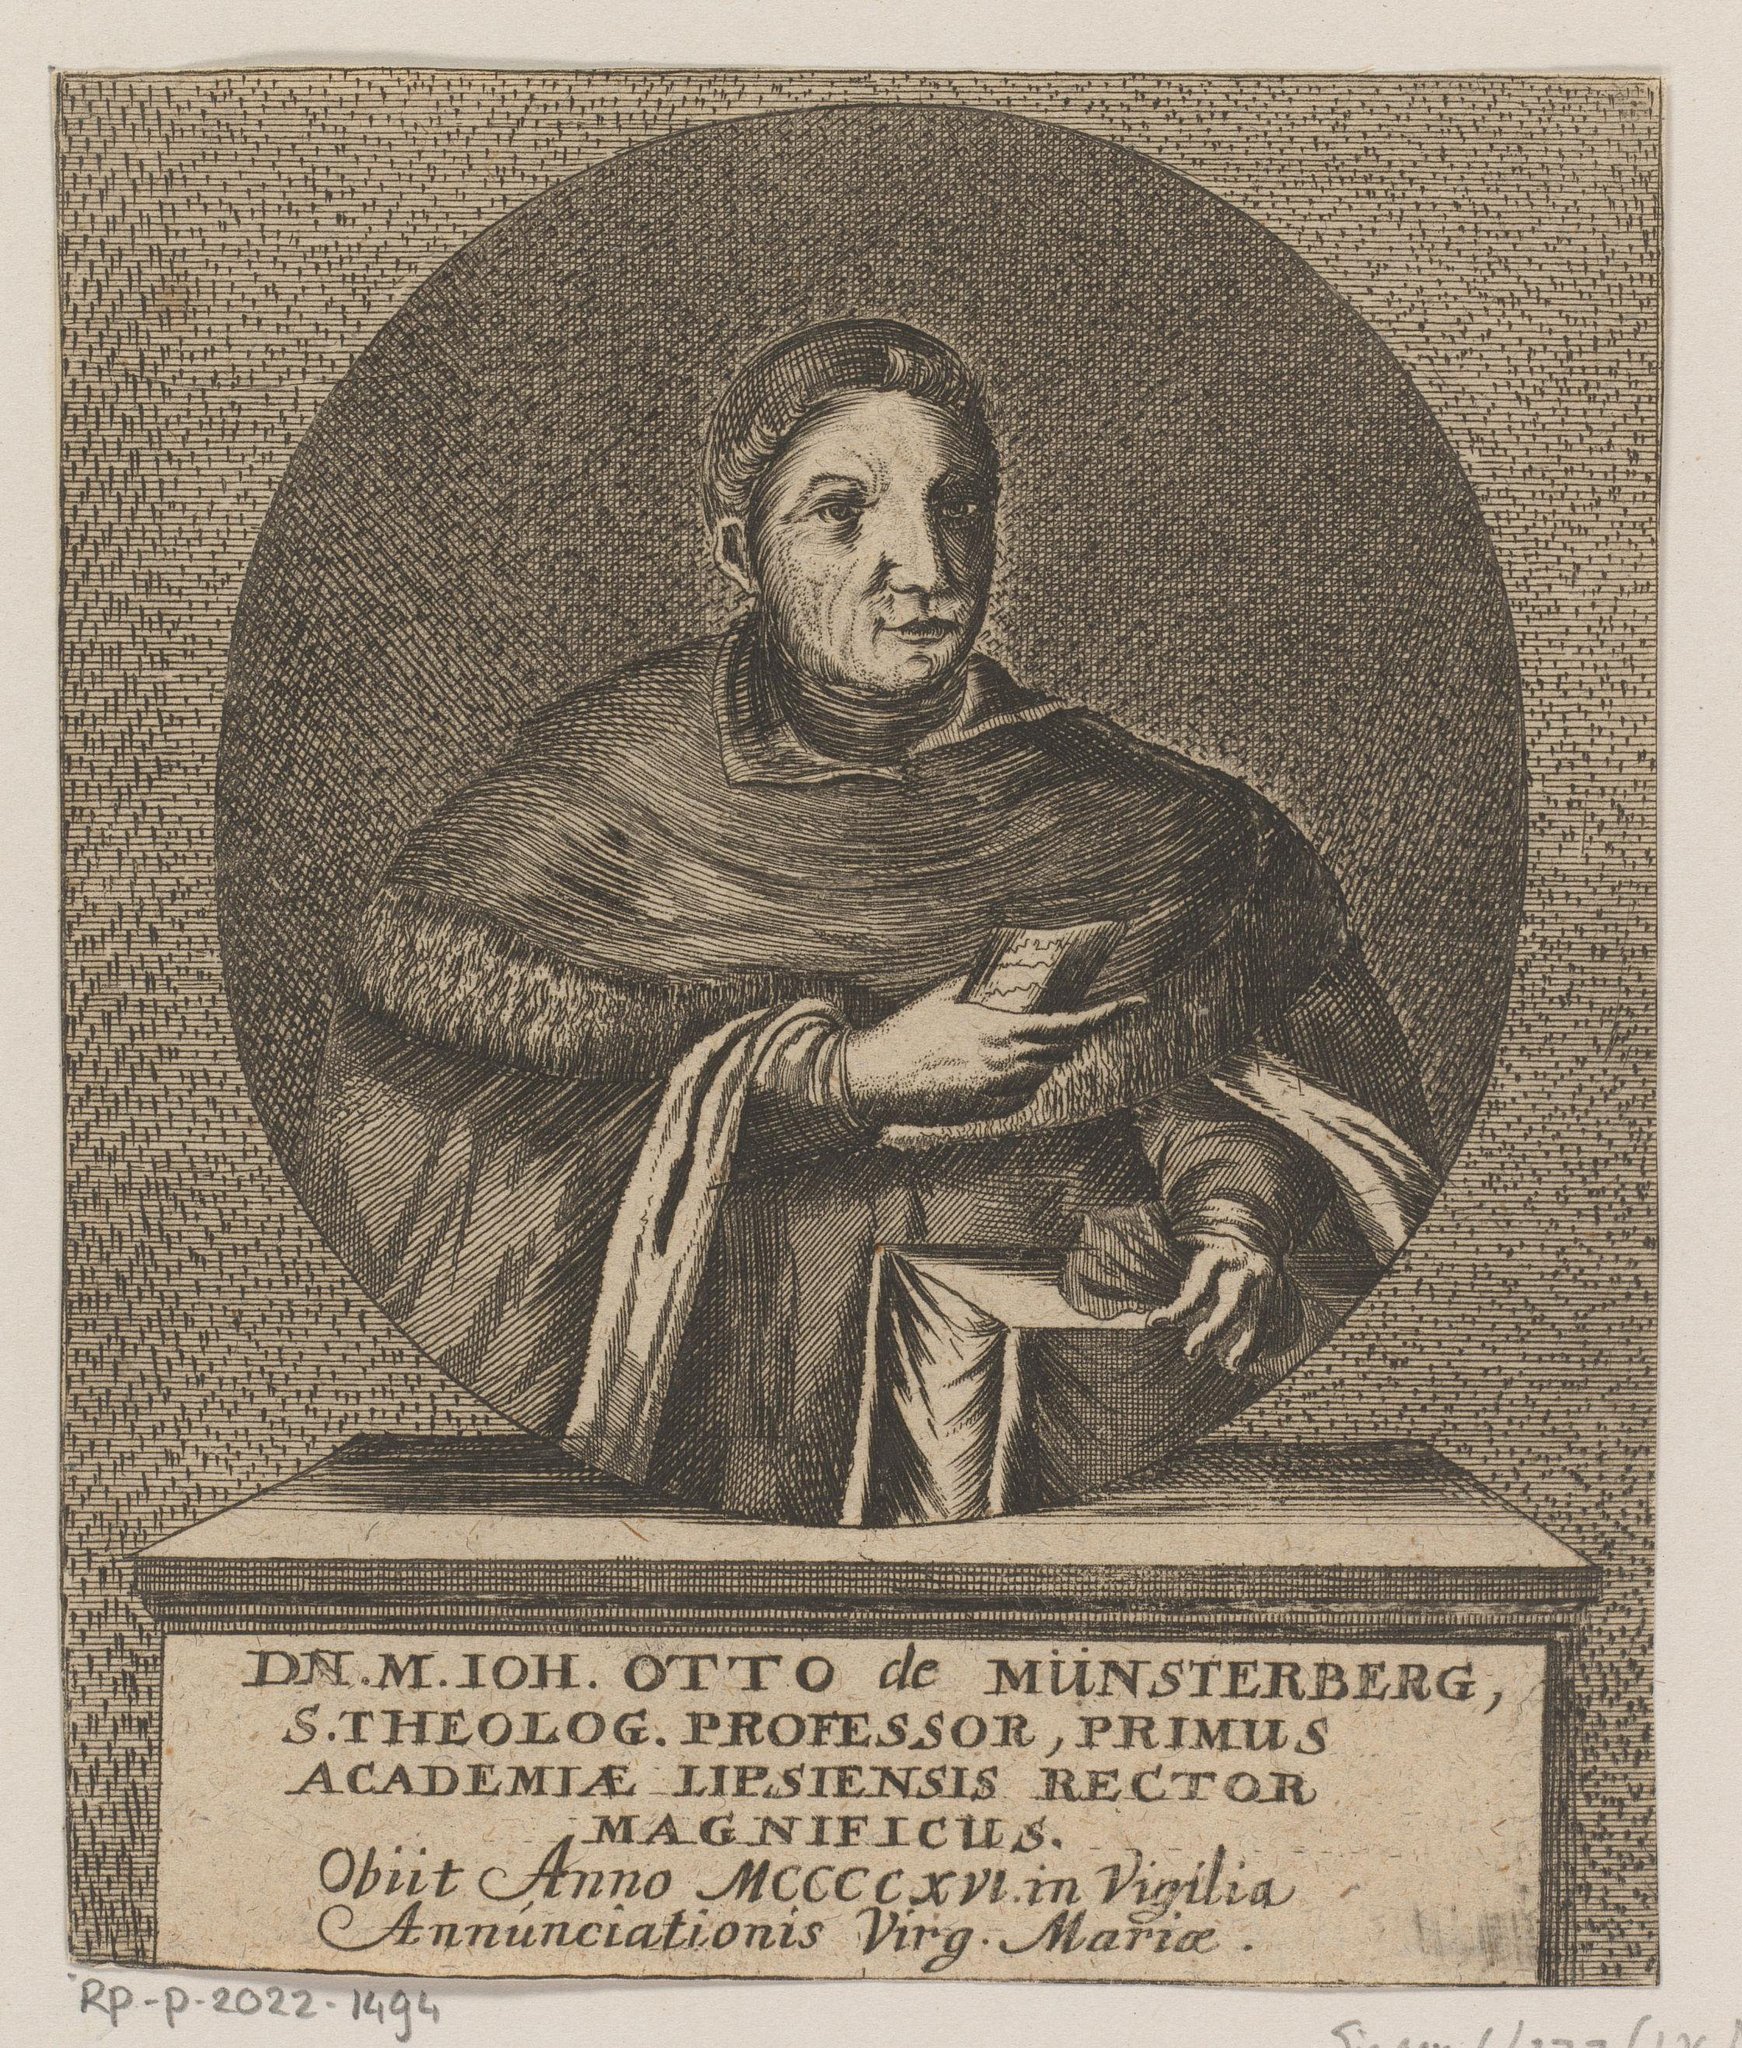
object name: print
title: DN. M. Ioh. Otto de Münsterberg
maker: Anonymous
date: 1550-1700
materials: paper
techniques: engraving, etching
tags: poland, theologian, historical persons